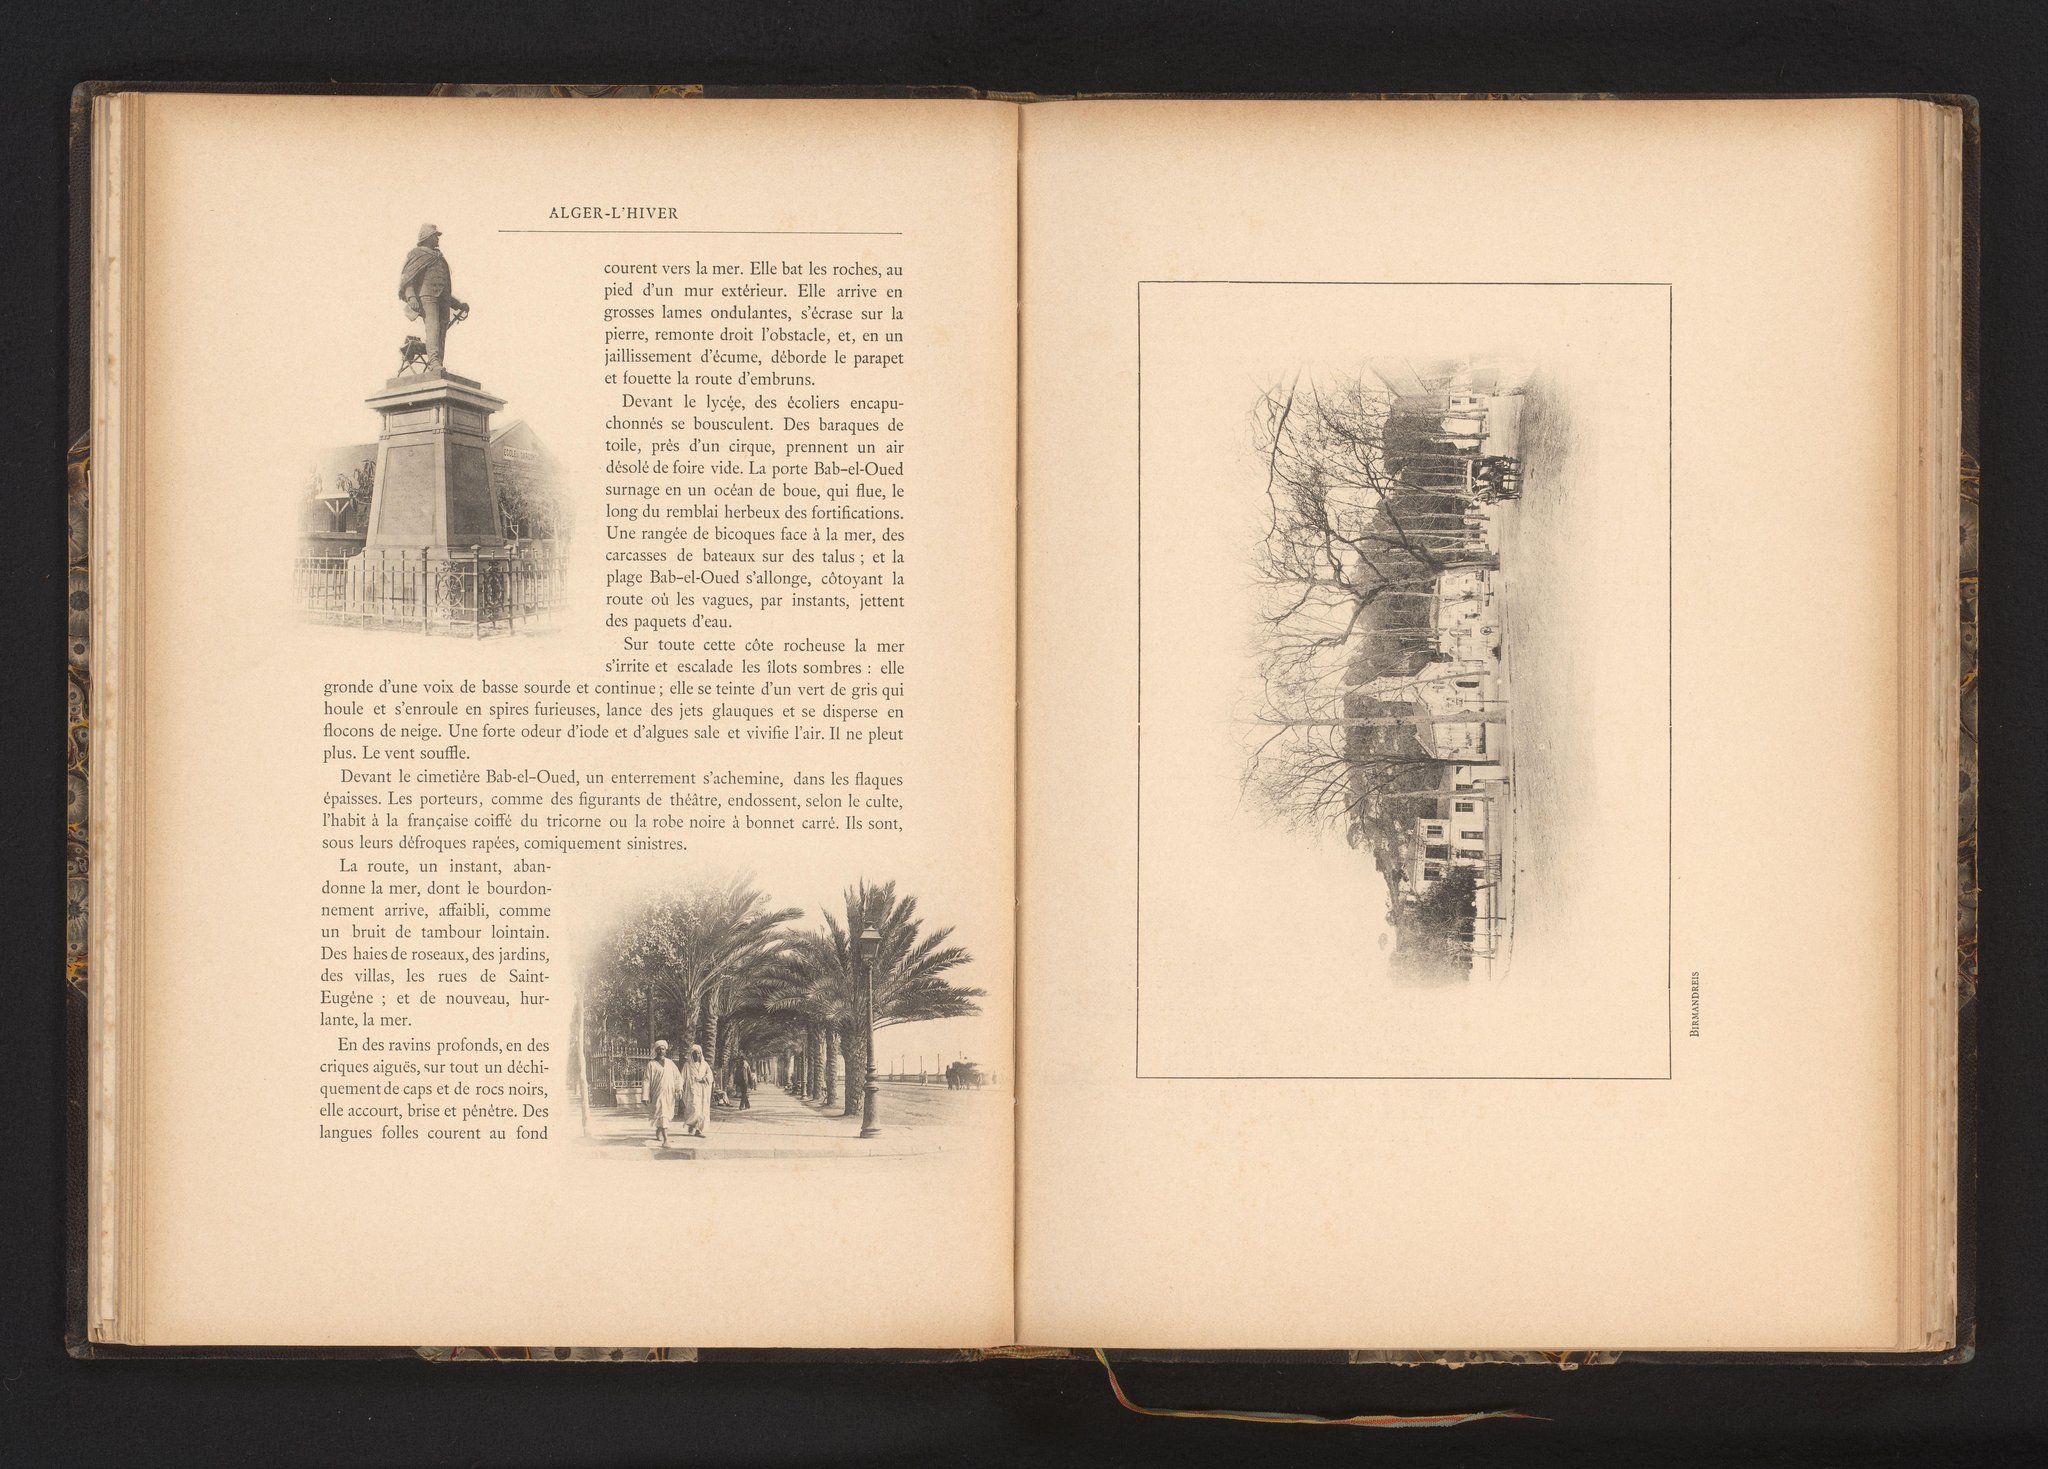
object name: page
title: Twee mannen op straat in Algiers, Algerije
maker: jules gervais-courtellemont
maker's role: fotograaf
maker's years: 1863-1931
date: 1888-1893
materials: paper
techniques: photograph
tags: adult man, street